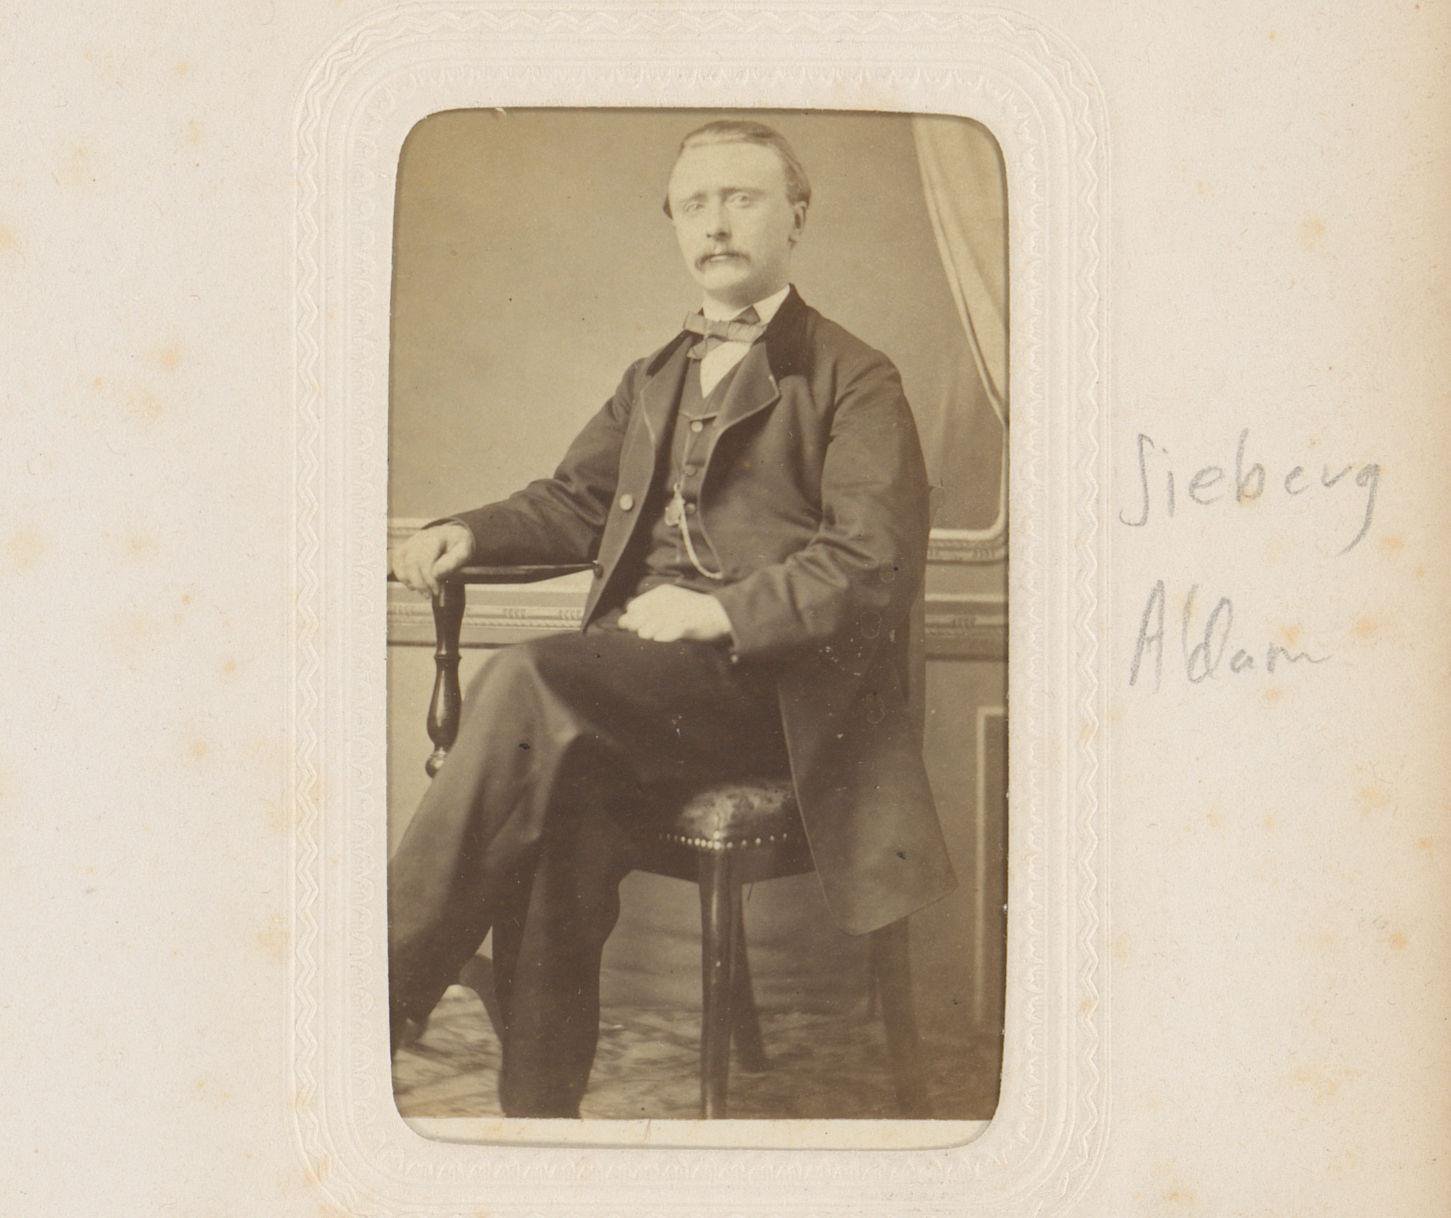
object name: carte de visite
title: Studioportret van een man met een snor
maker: f sieberg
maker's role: fotograaf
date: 1863-1866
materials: cardboard, paper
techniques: albumen print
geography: amsterdam